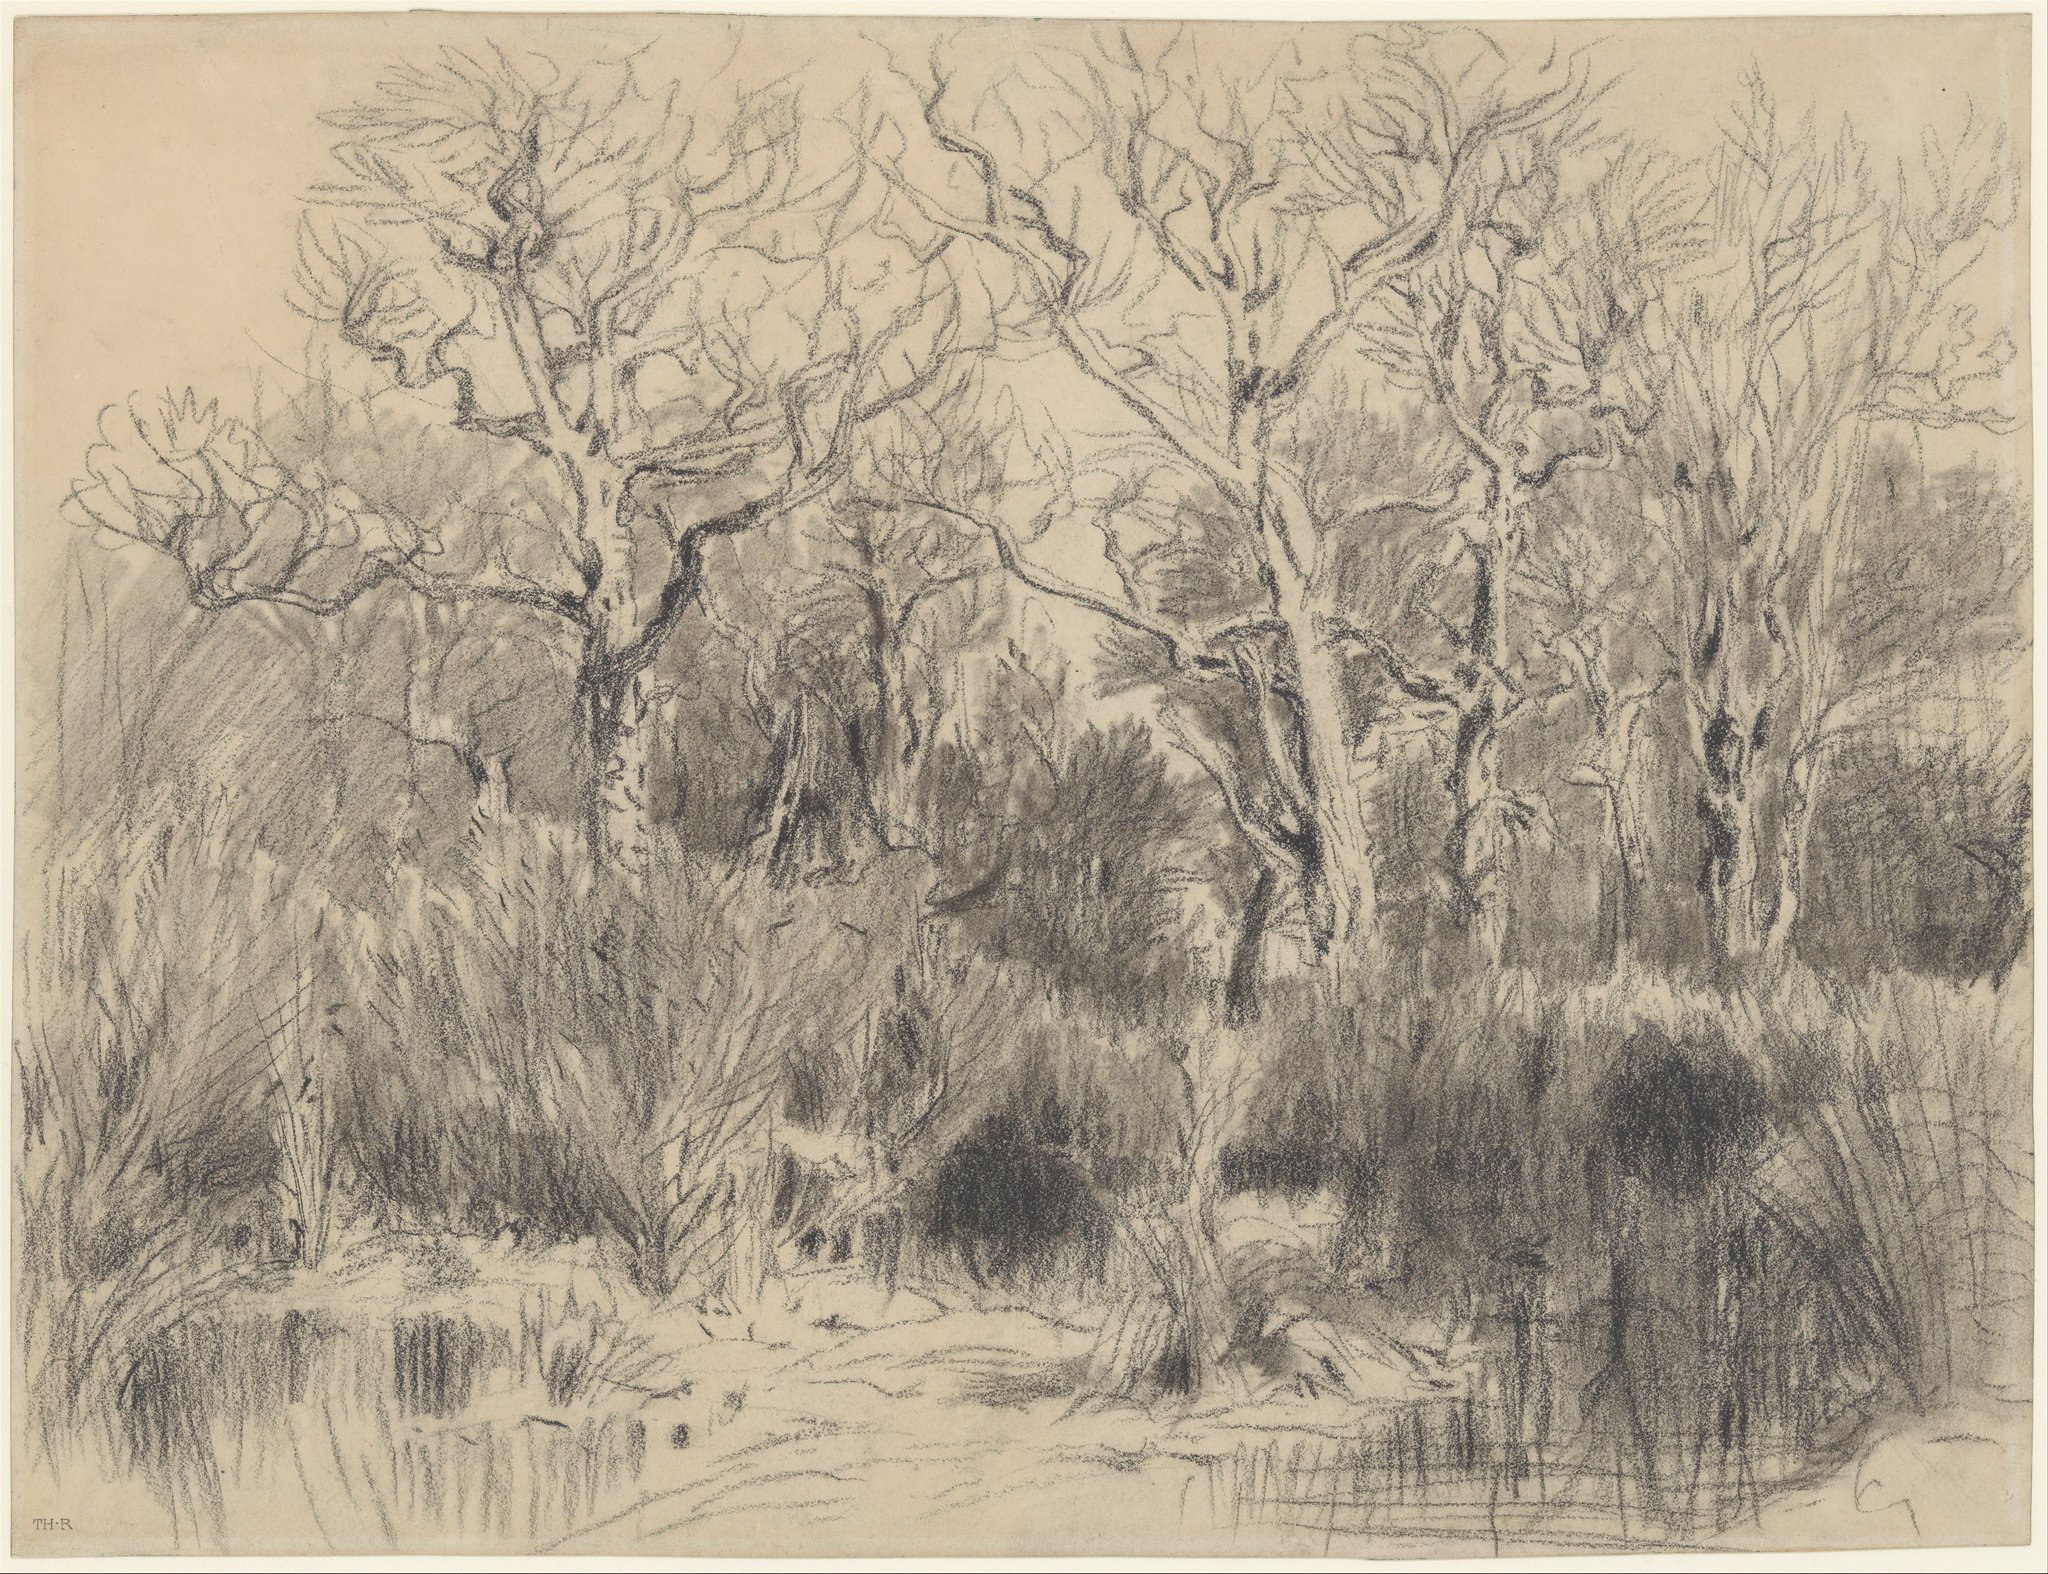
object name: drawing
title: Trees in a Thicket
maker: théodore rousseau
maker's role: artist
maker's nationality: french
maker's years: 1812-1867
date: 1845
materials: crayon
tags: trees